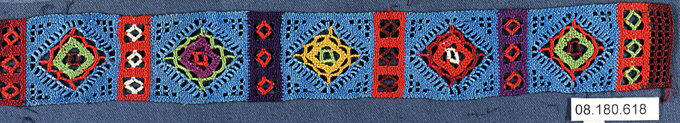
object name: fragment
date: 1801-1900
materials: silk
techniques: lace